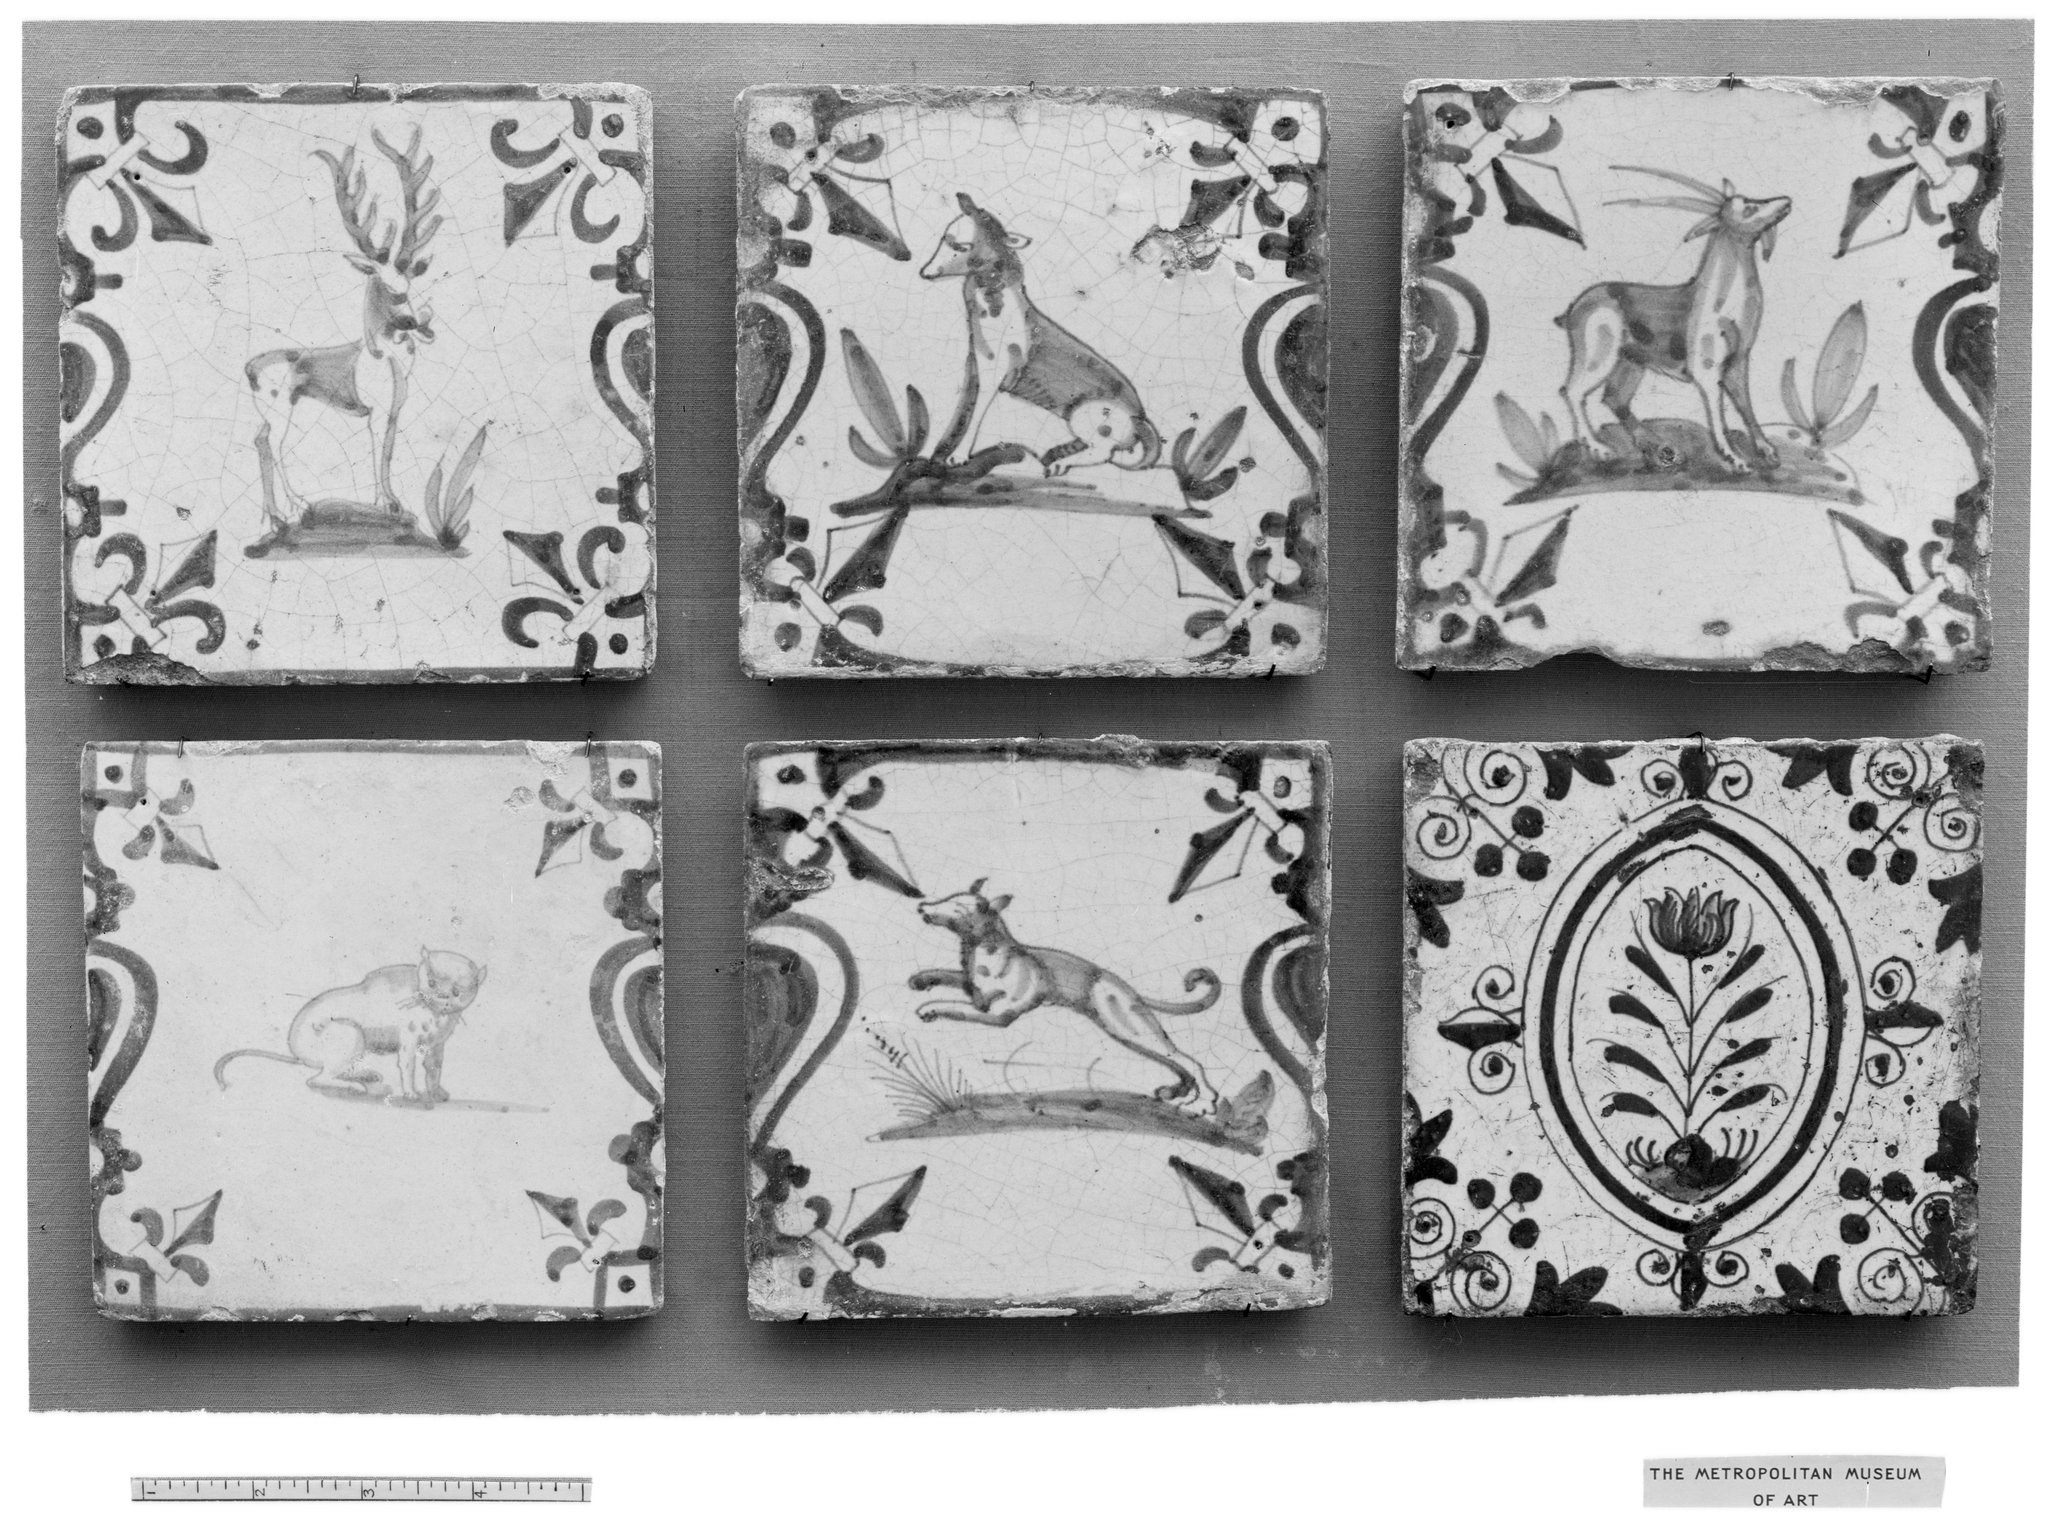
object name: tile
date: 1620-1640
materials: earthenware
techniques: glazing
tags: cats,deer,dogs,goats,flowers